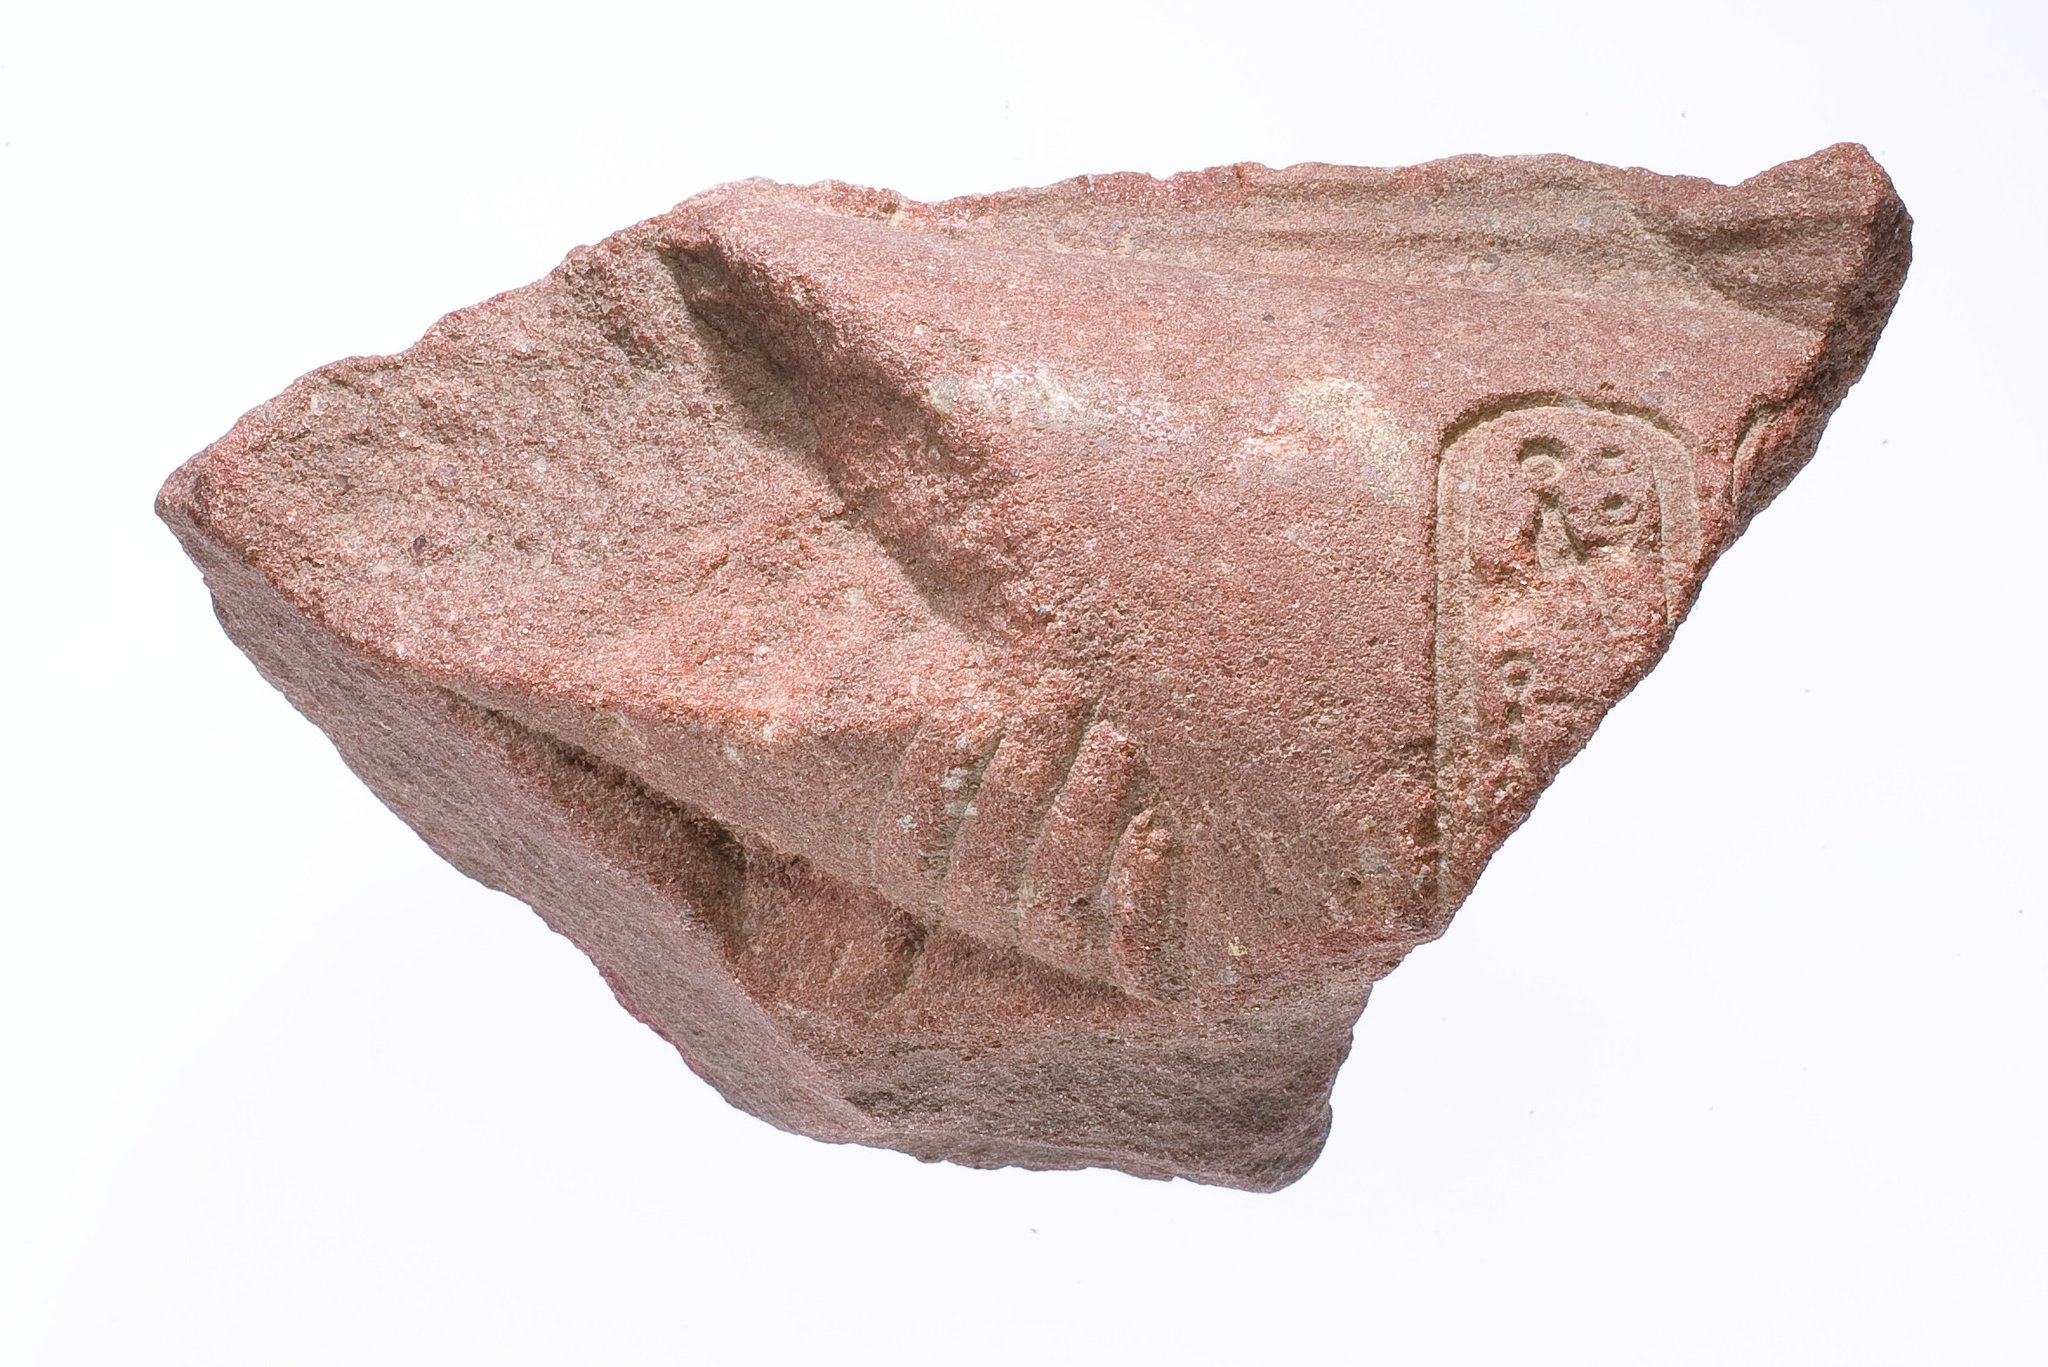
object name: forearm of bent arm, aten cartouch, hand of aten ray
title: Forearm from a bent royal arm crossing the front profile of figure's body and the rear profile of a second figure, arm marked with Aten cartouches, supported by the hand of an Aten ray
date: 1353-1336 BCE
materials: quartzite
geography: egypt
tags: cartouches